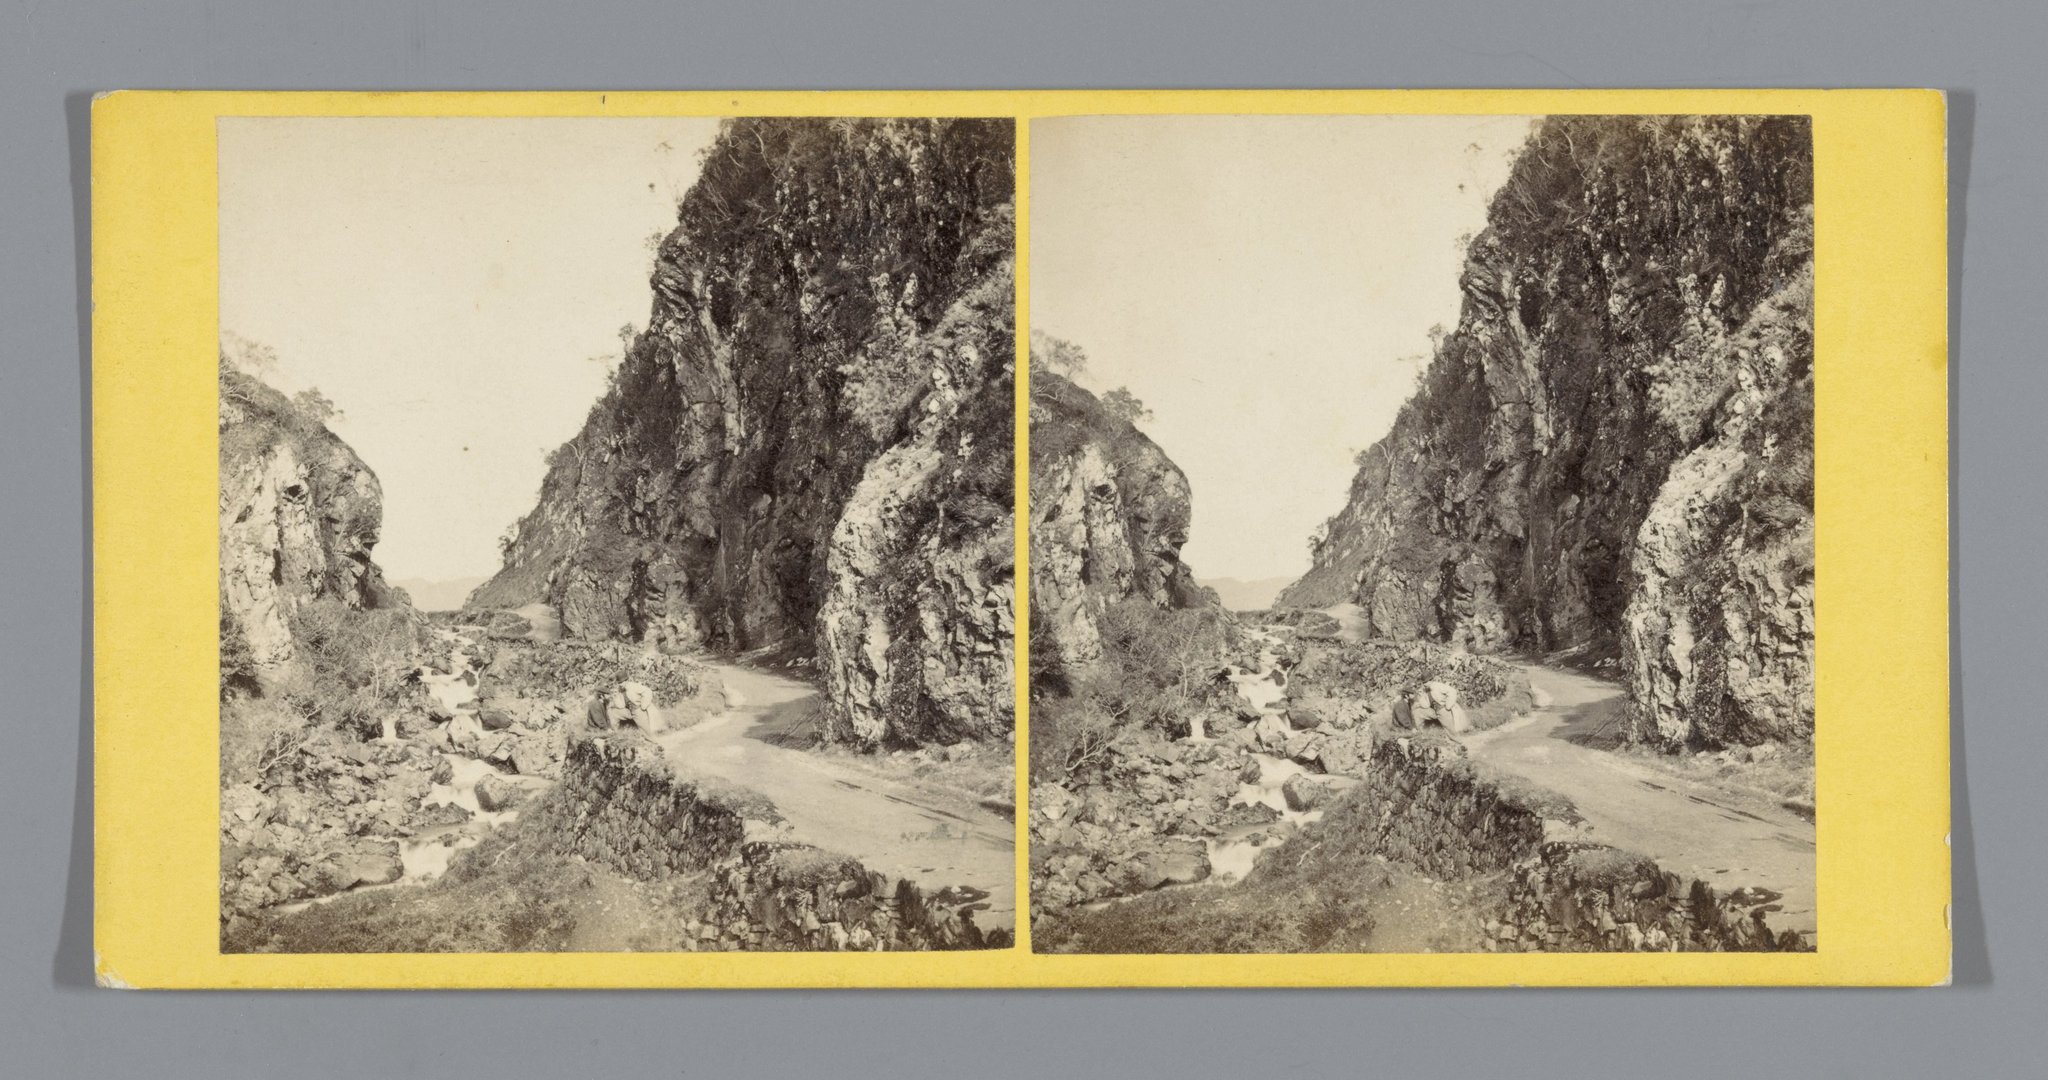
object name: stereograph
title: Gezicht op de Pass of Melfort vlakbij Oban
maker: george washington wilson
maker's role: publisher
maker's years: 1823-1893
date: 1858-1872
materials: cardboard, photographic support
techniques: albumen print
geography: oban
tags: river, rock-formations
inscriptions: number: ‘No. 742 A.’